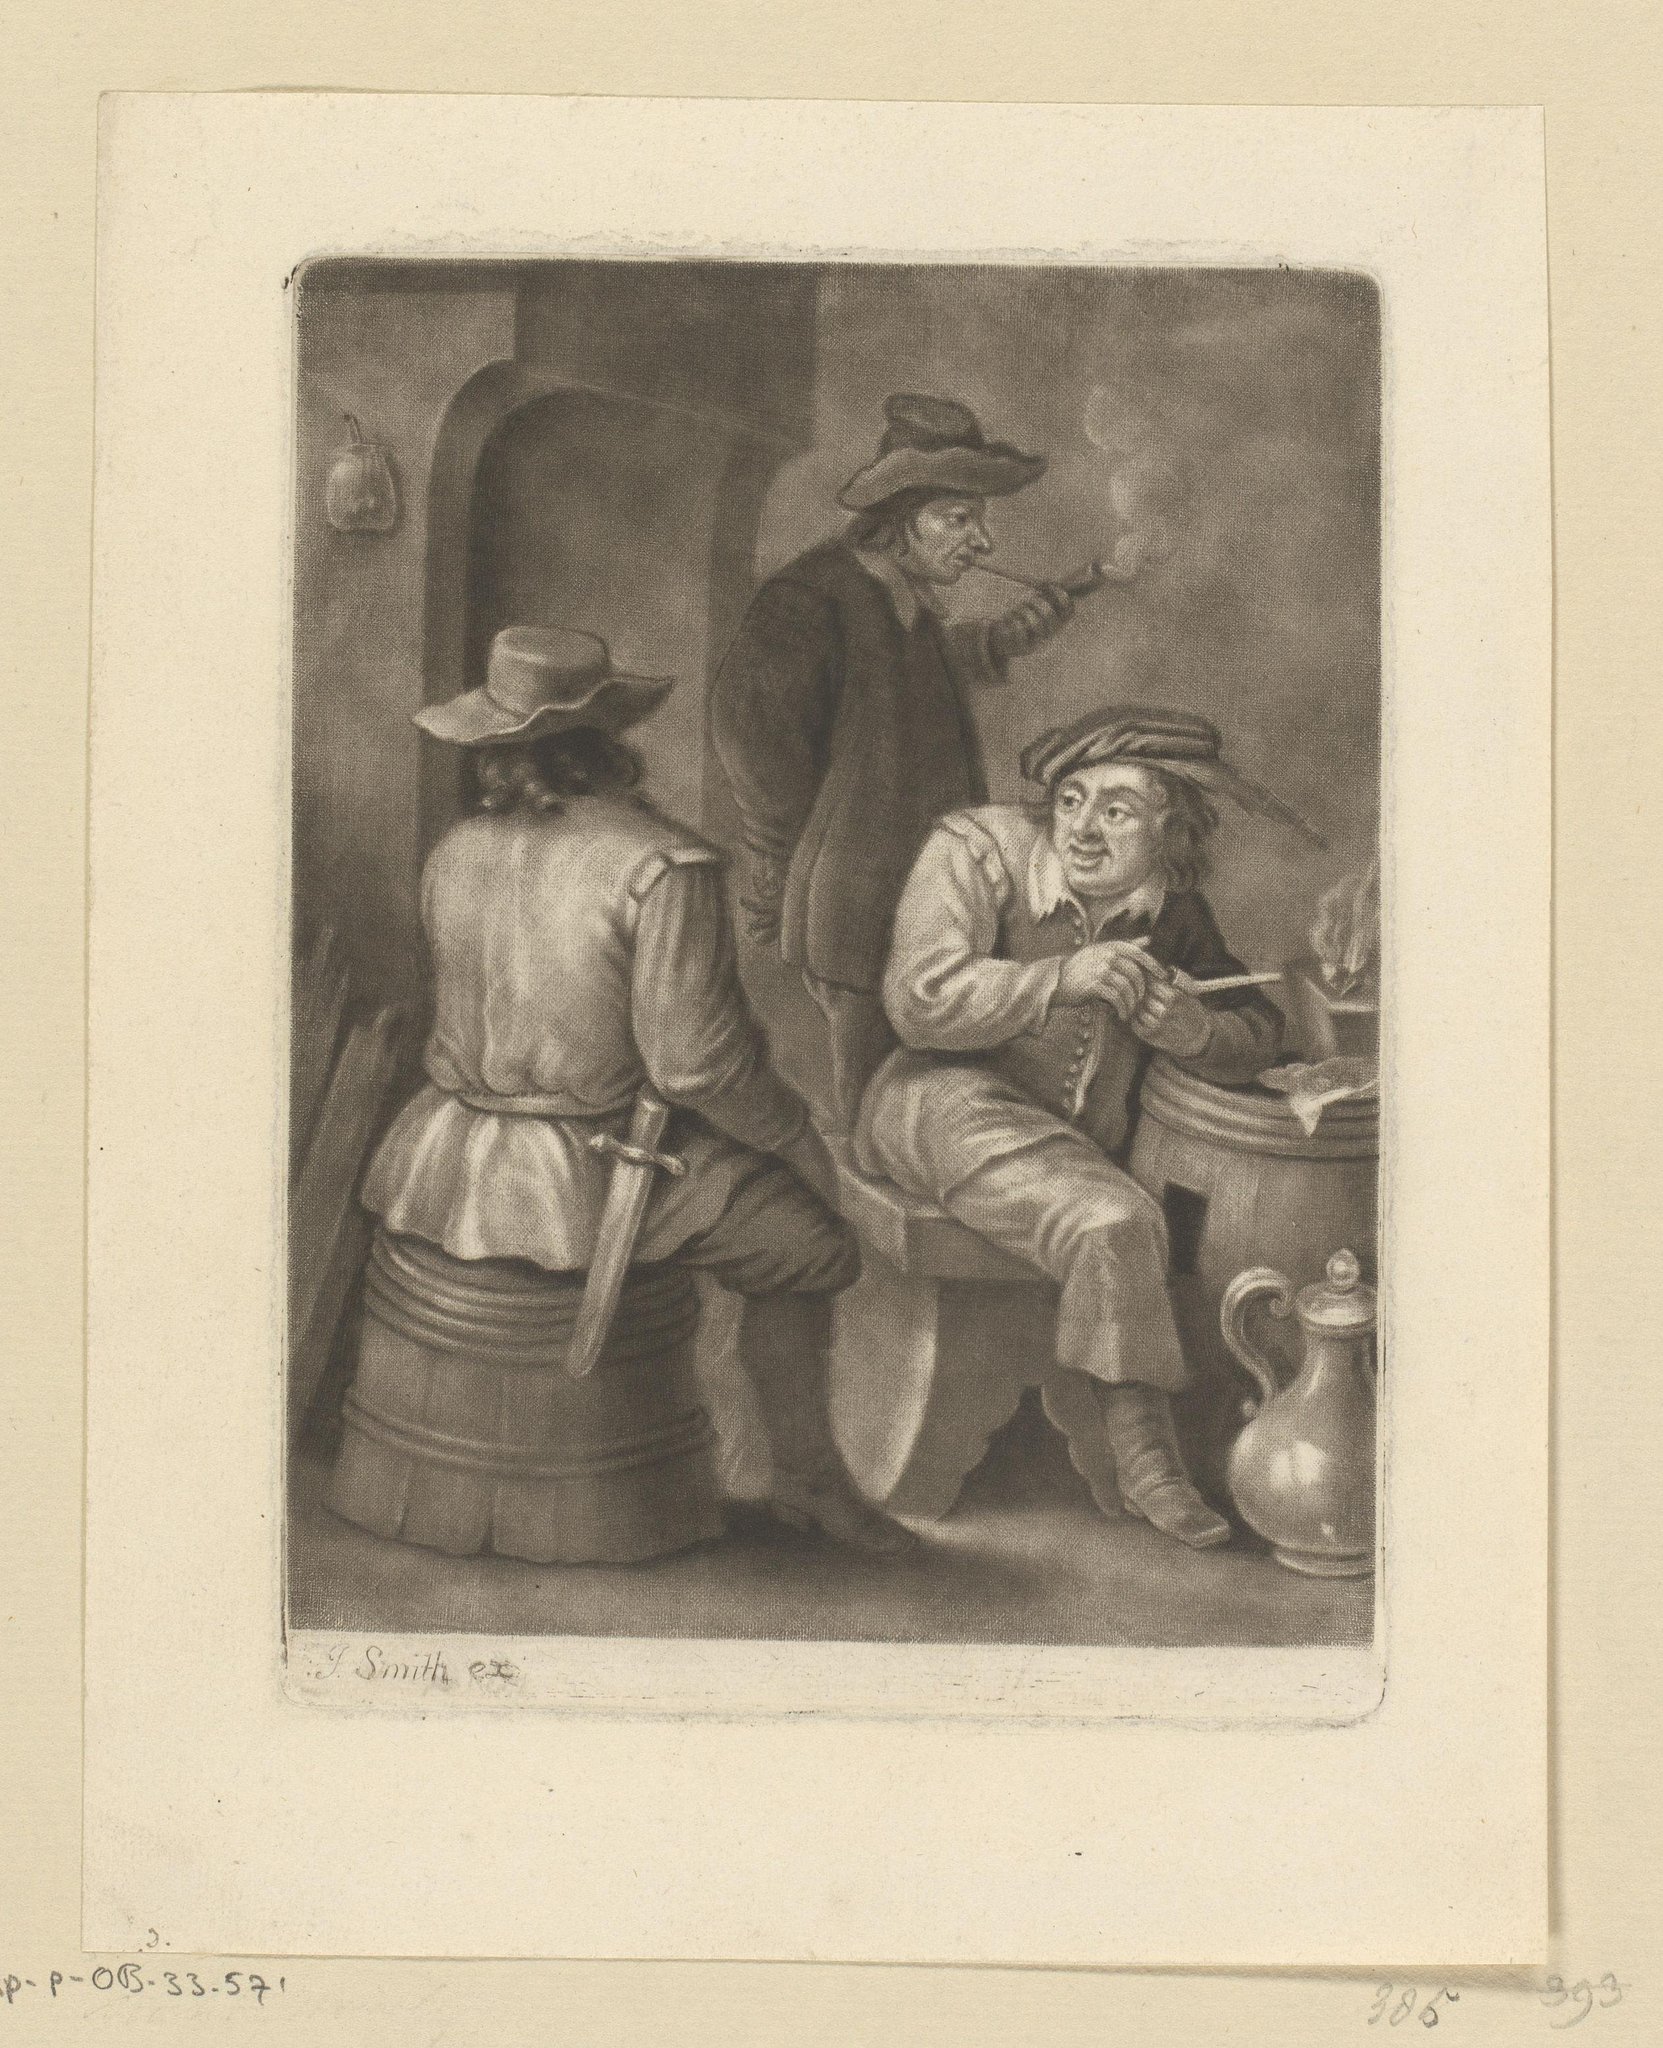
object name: print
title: Herberginterieur met twee rokers en man zittend op vat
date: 1680-1720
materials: paper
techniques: mezzotint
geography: england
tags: wooden container: barrel, cask, bucket, pipe ~ tobacco (+ taking (particular) foodstuffs: eating, drinking, smoking, chewing, etc.), hotel, hostelry, inn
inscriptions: collector's mark: Lugt 240